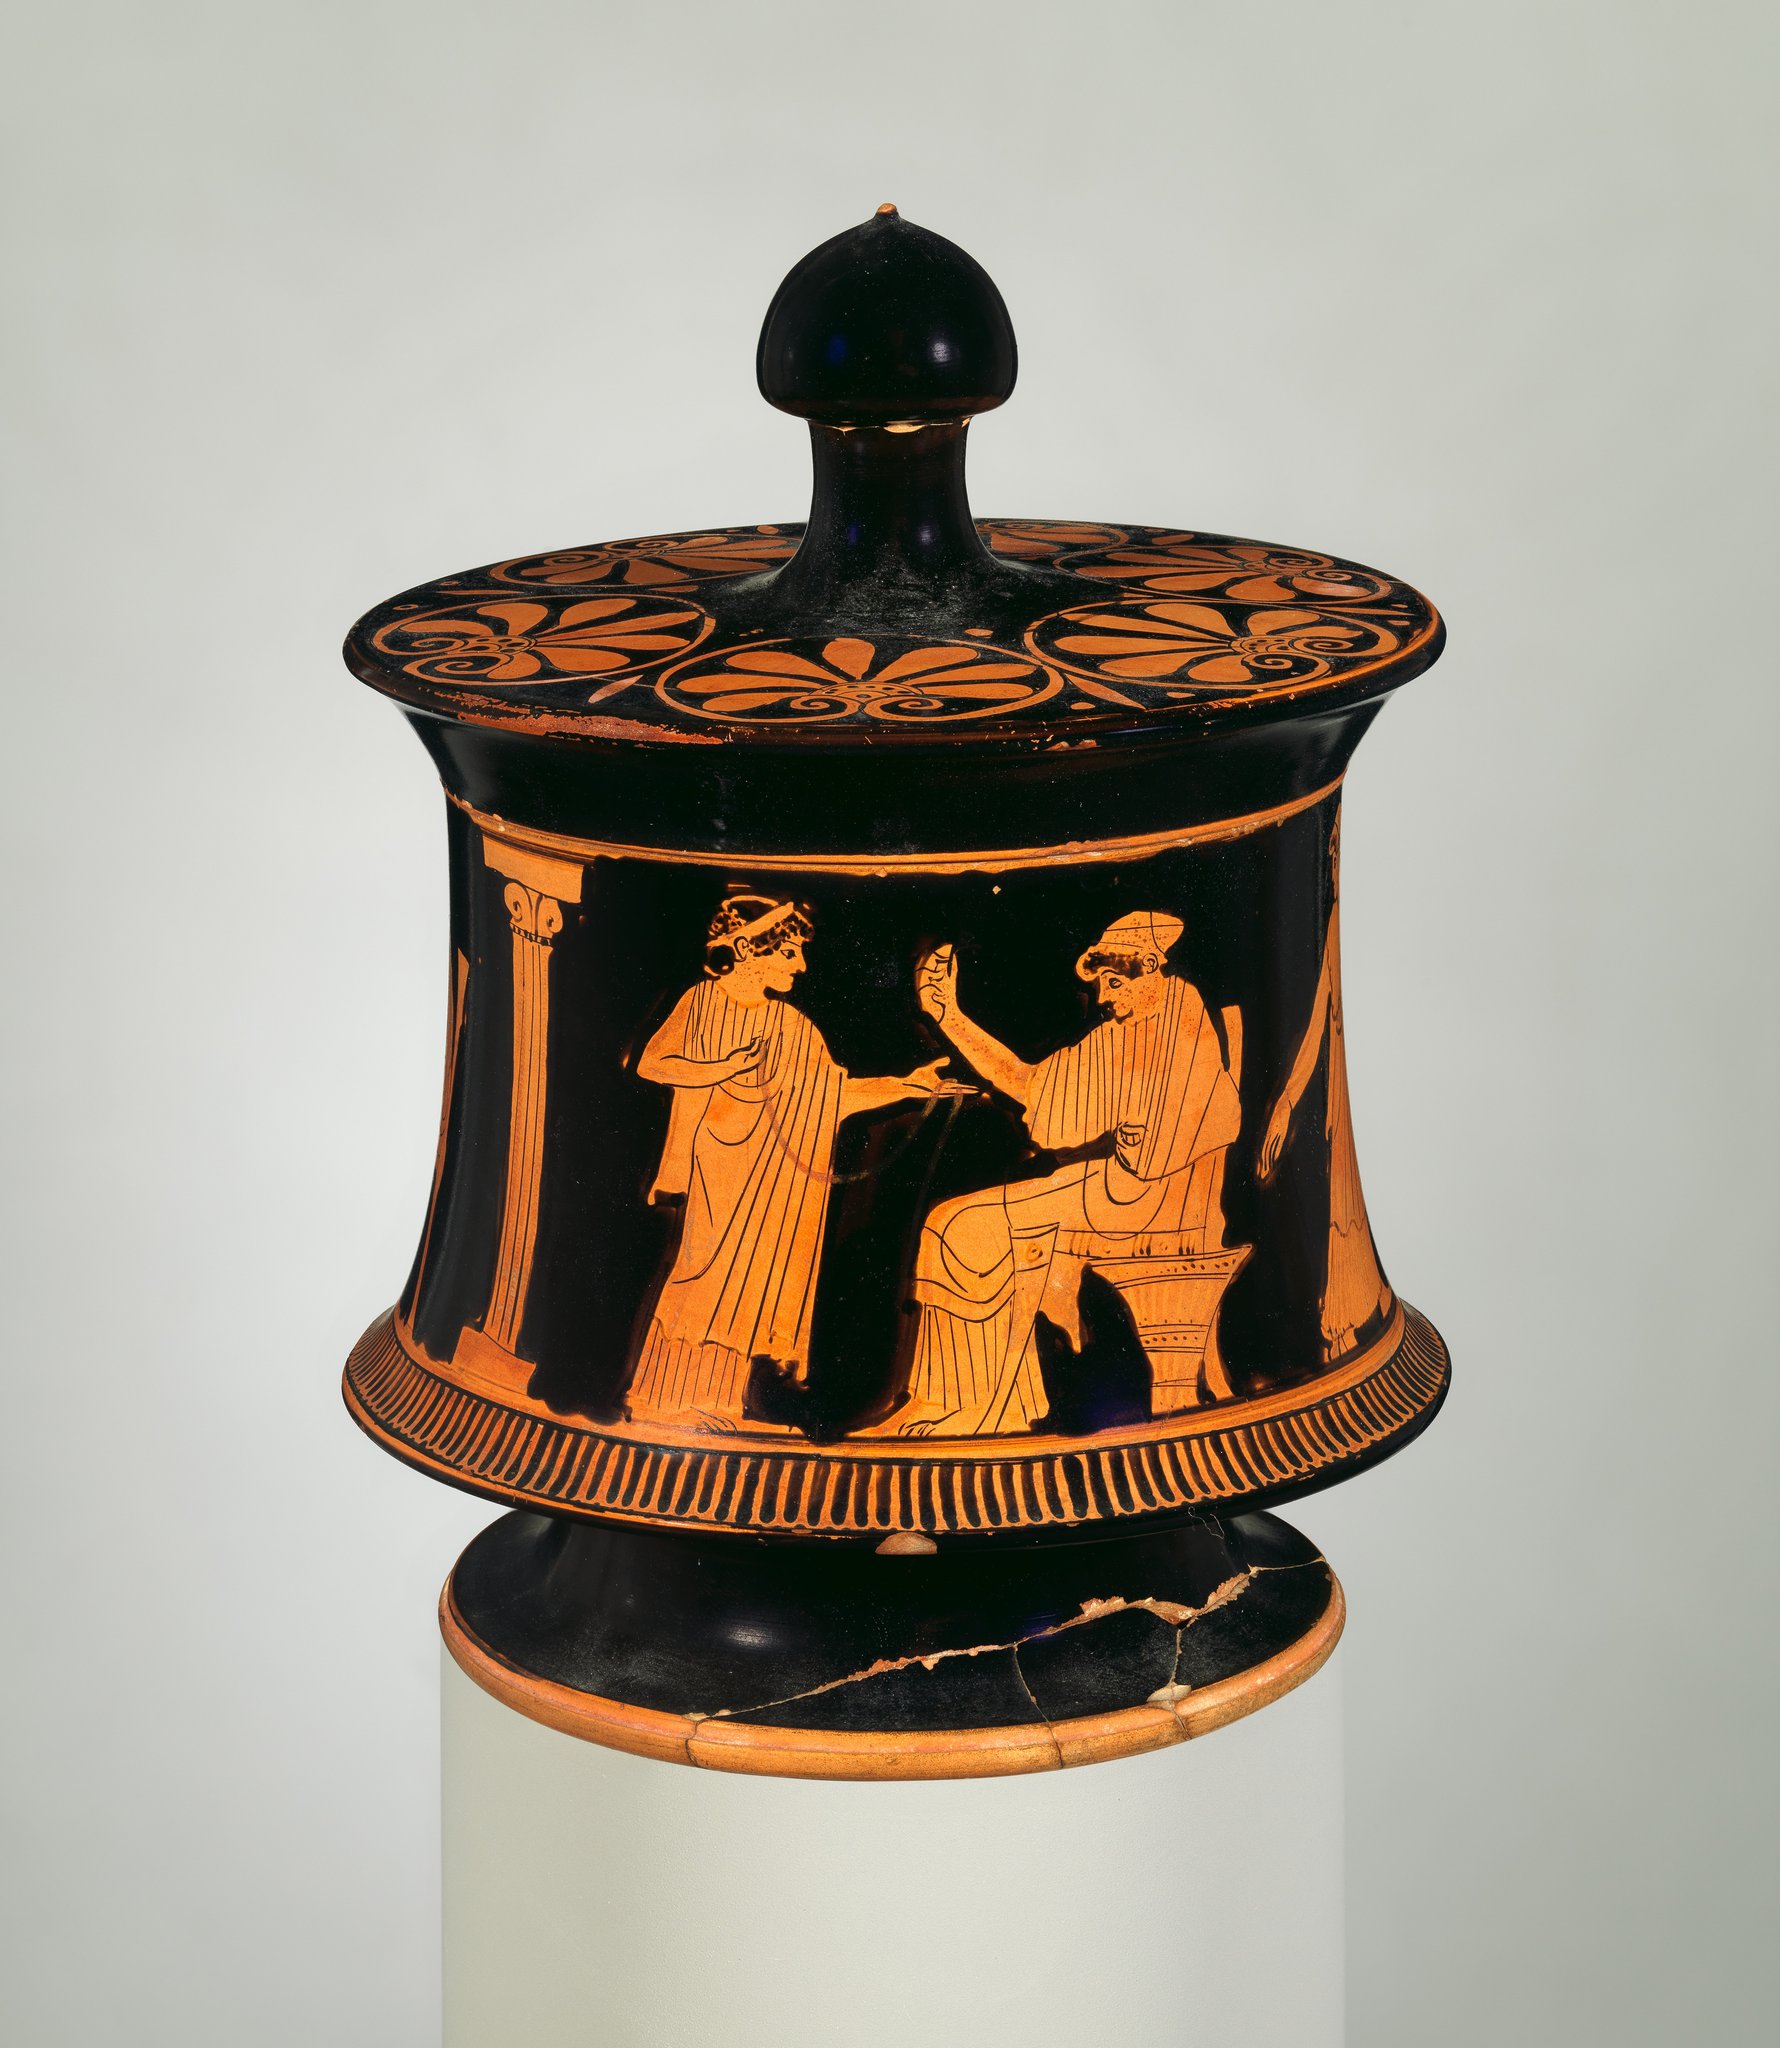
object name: pyxis with lid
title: Terracotta pyxis (box) with lid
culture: greek, attic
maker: painter of philadelphia 2449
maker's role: artist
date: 460 BCE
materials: terracotta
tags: women,spindles